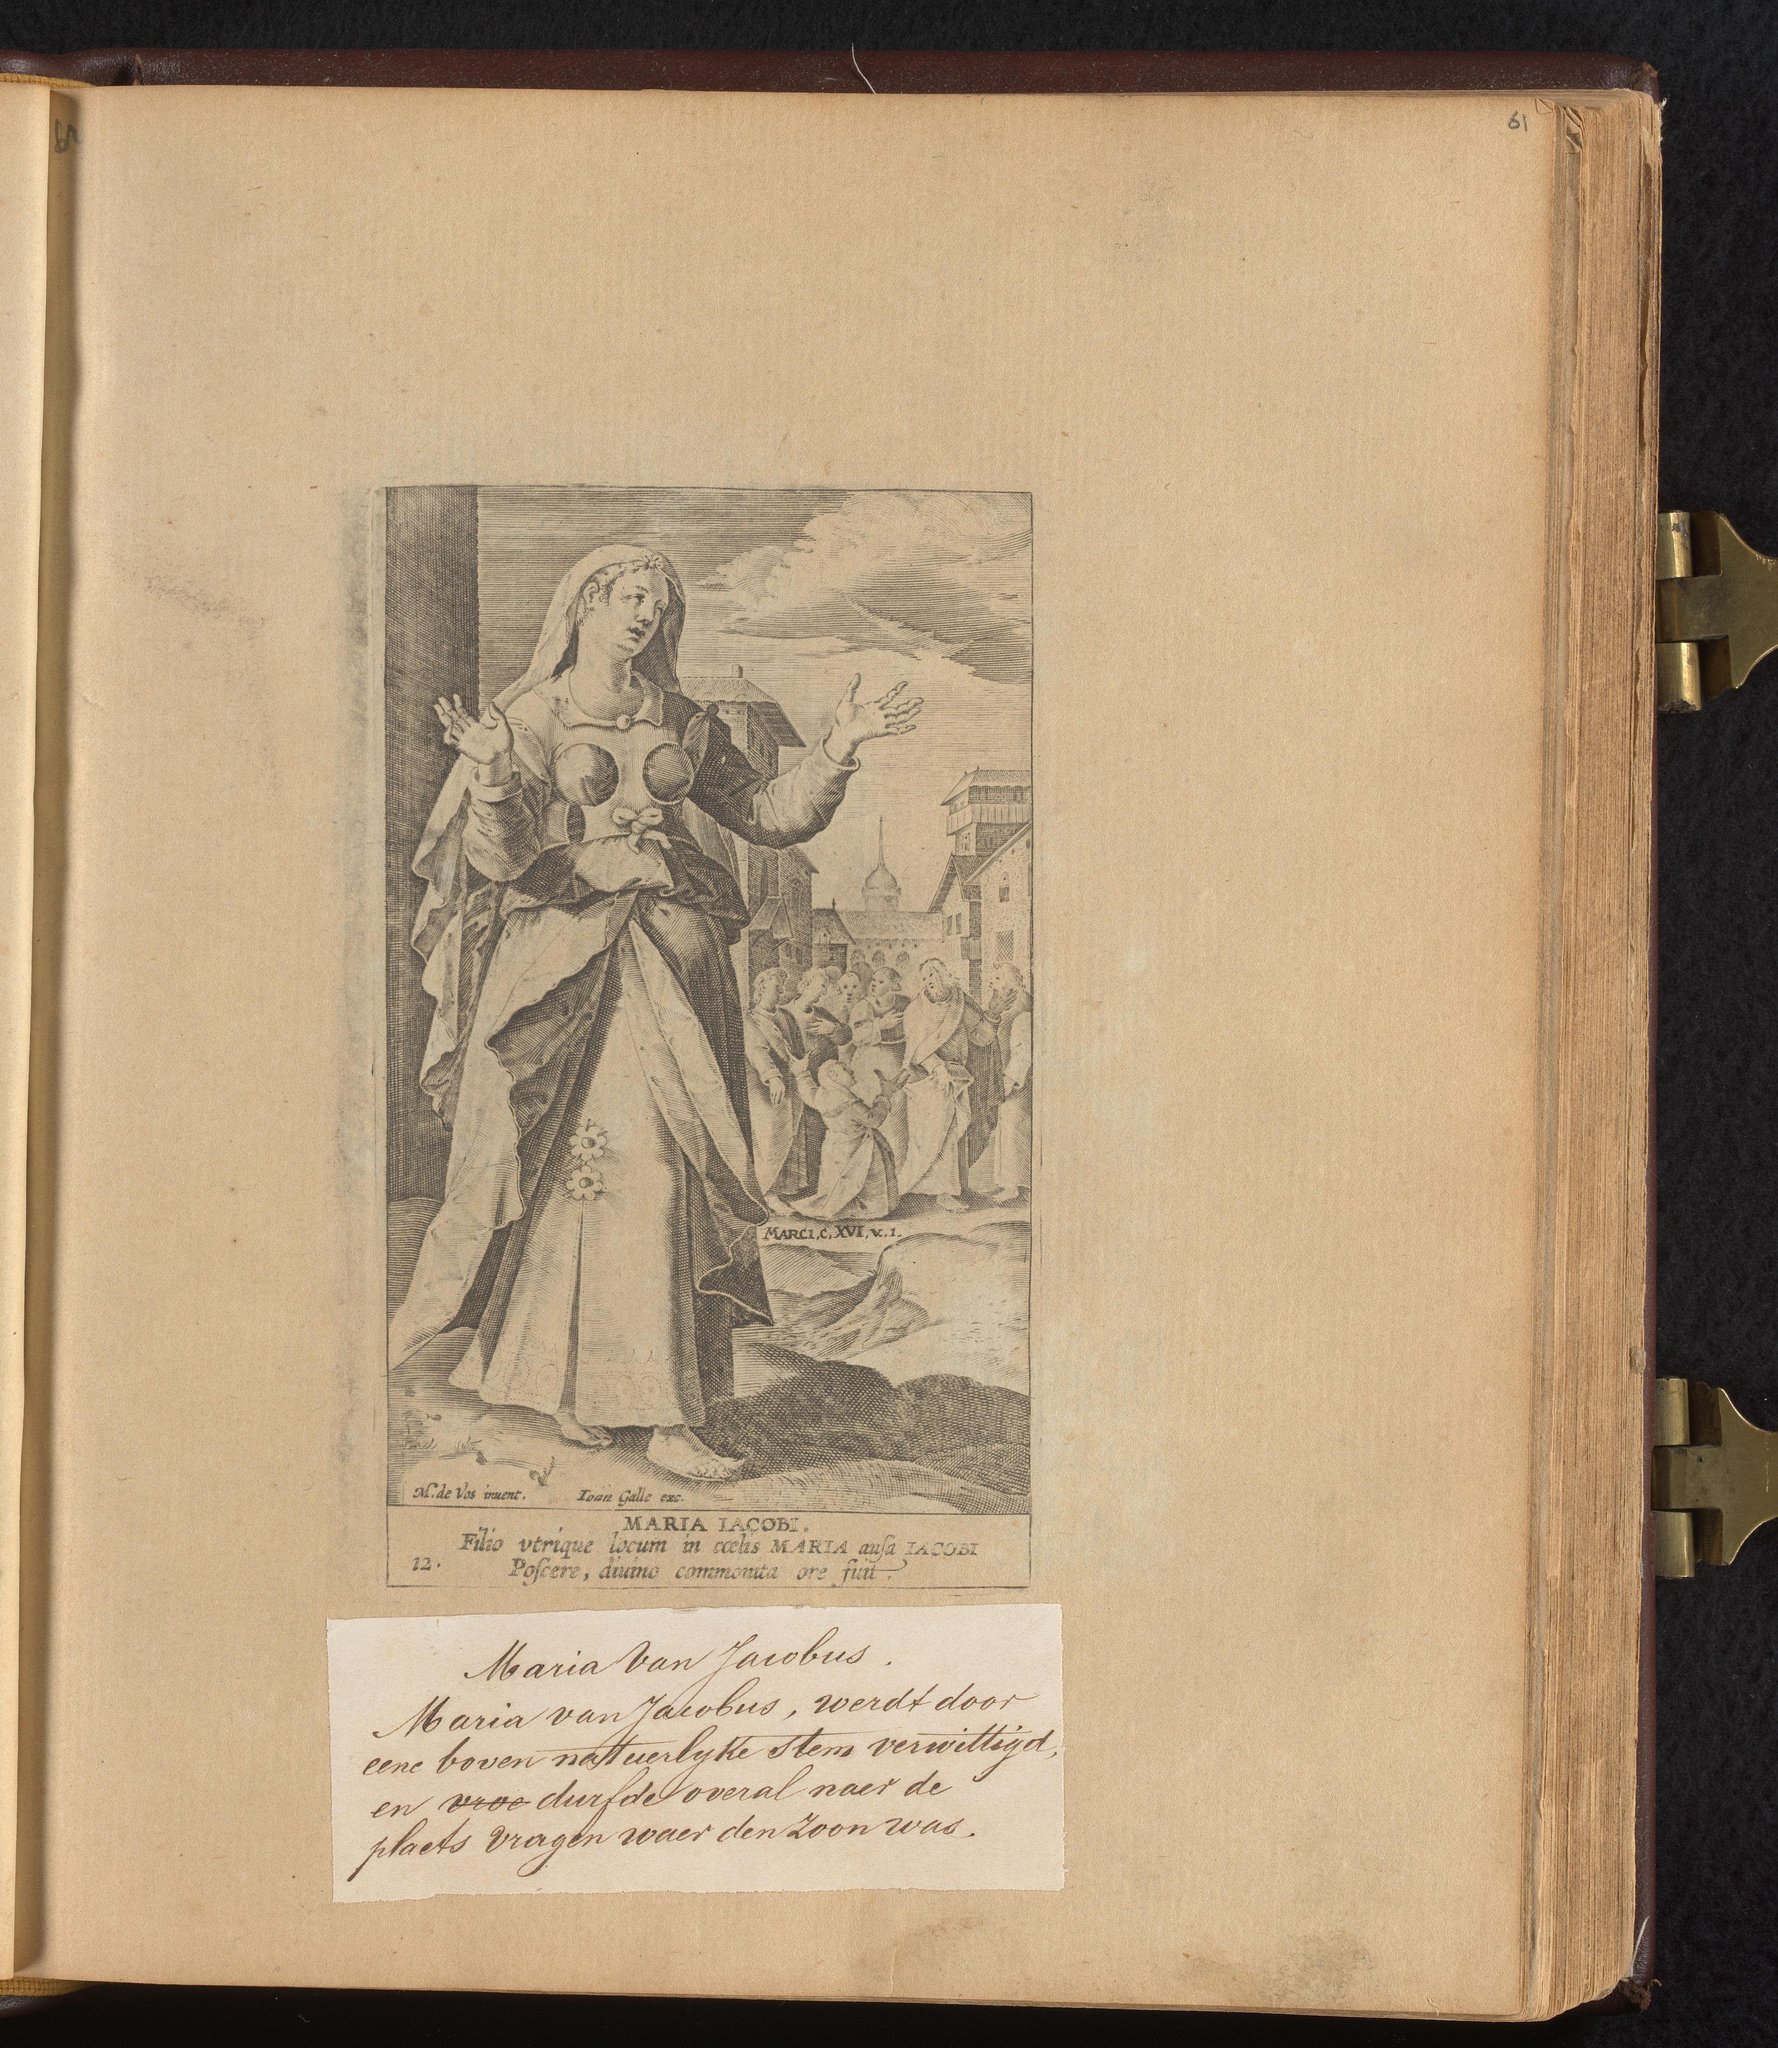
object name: print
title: Maria Iacobi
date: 1599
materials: paper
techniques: engraving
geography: antwerp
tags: request of the mother of the sons of zebedee (matthew 20:20-21)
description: Prent maakt deel uit van een prentbijbel.